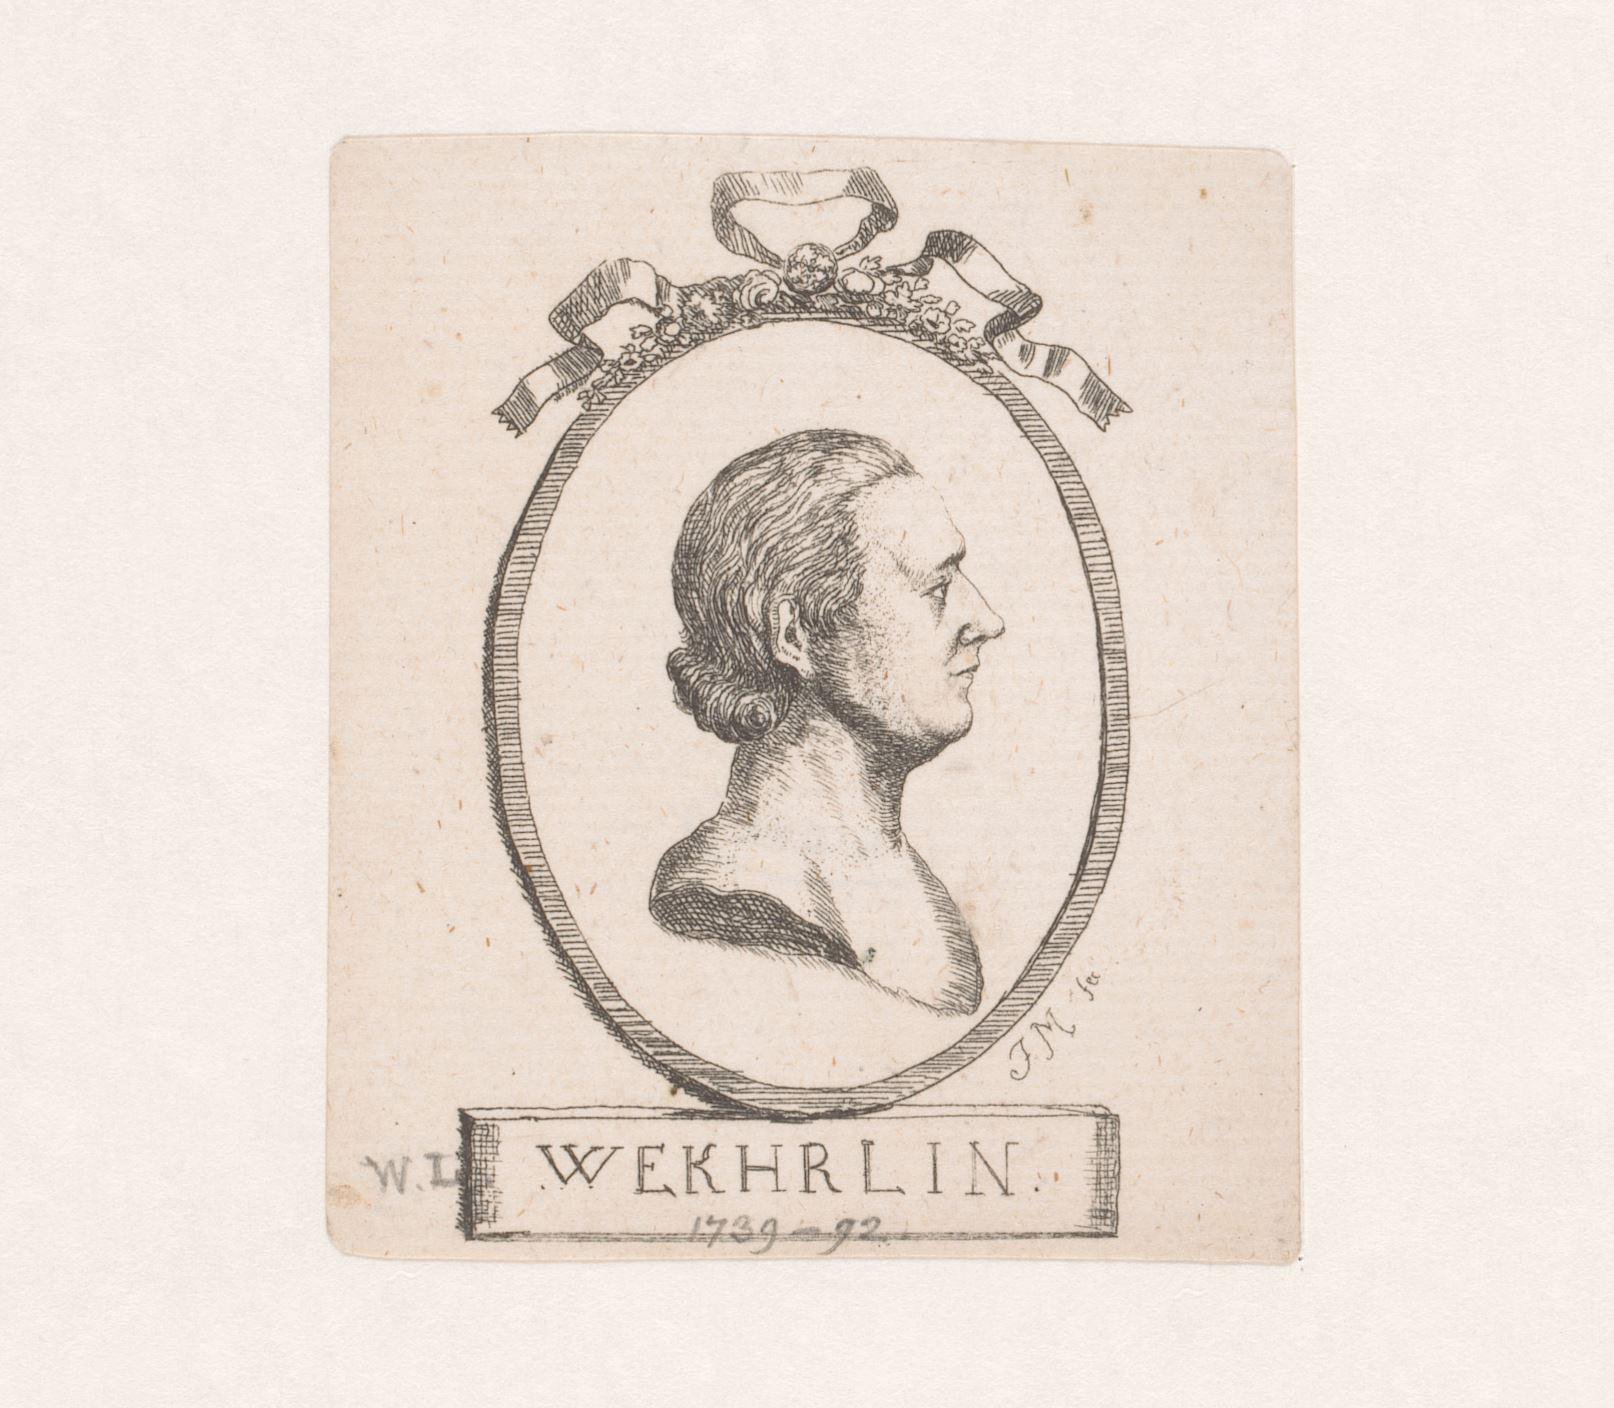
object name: print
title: Portret van Wilhelm Ludwig Wekhrlin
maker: j. muller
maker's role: print maker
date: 1749-1799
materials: paper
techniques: etching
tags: publisher, historical persons, writer, poet, author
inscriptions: date: ‘1739-92’, initials: ‘W.L.’, collector's mark: Lugt 2228